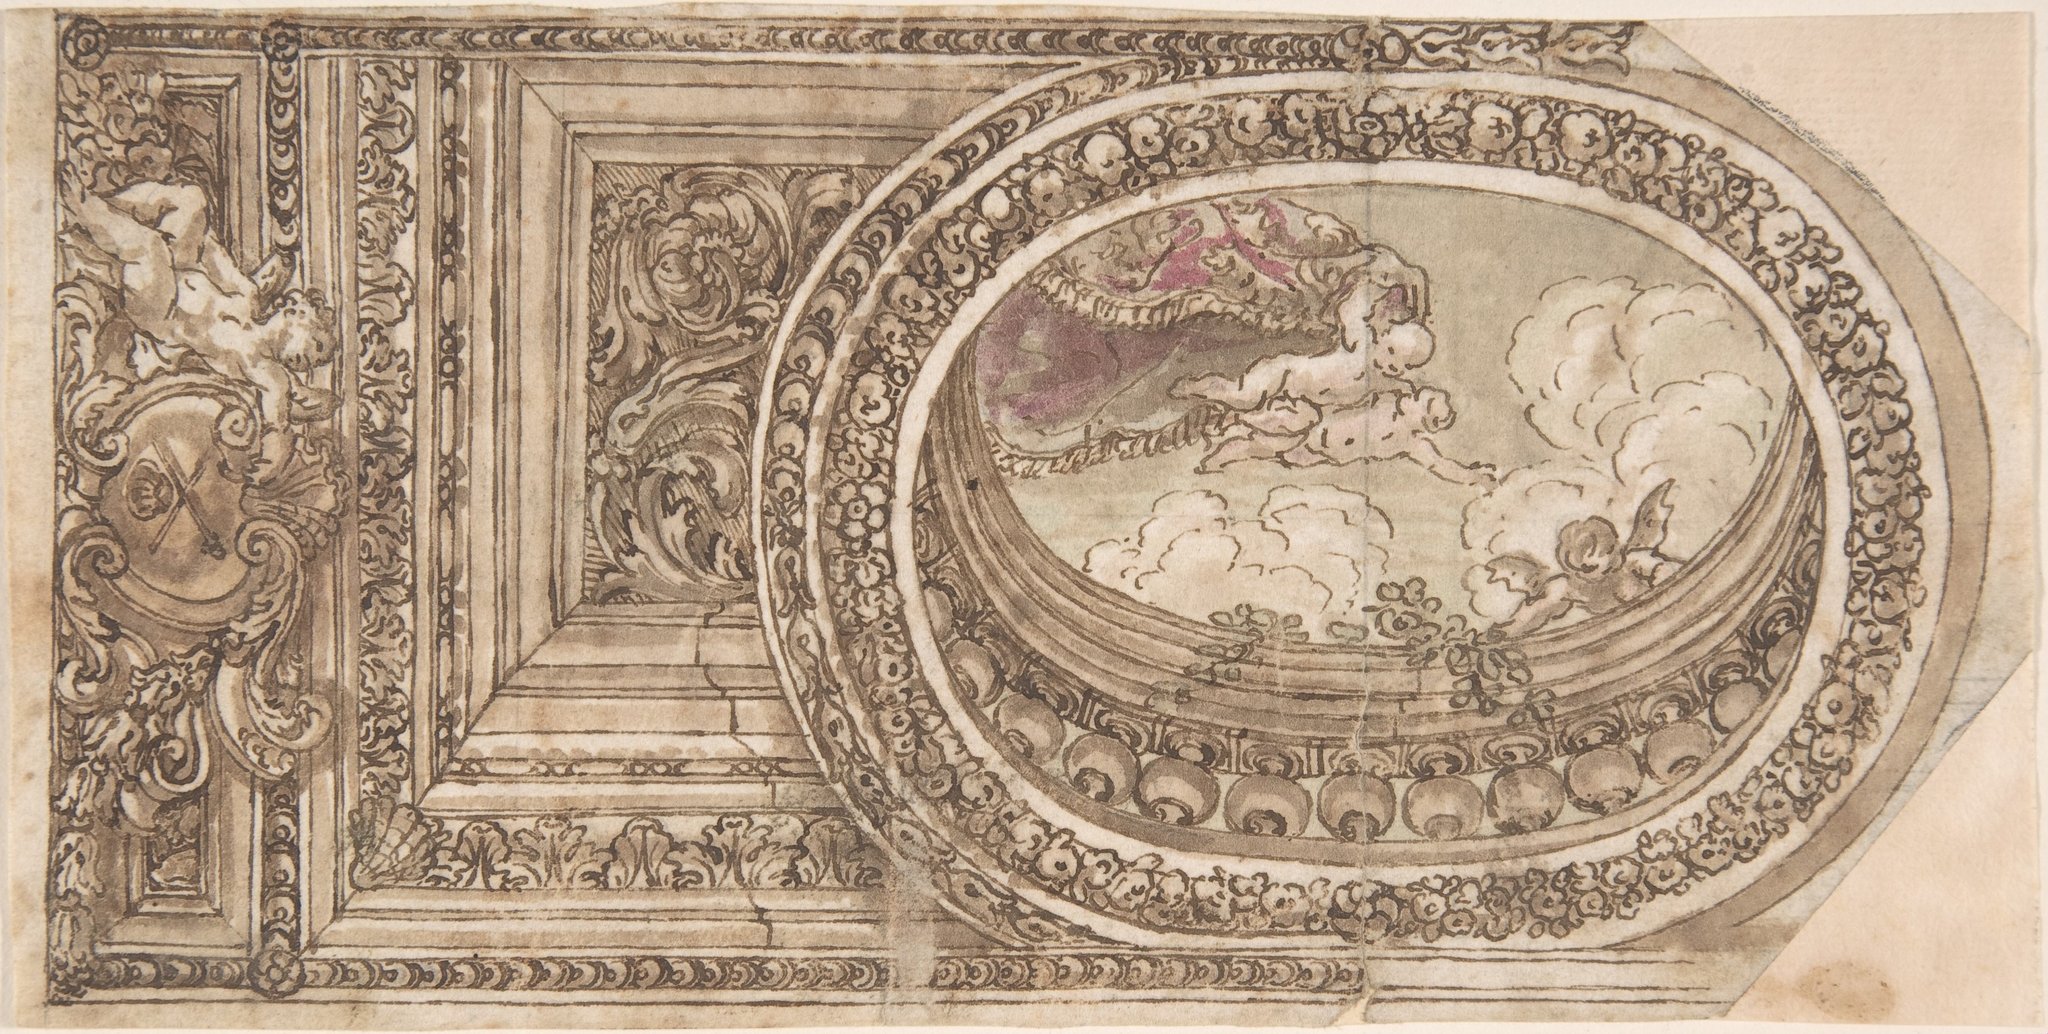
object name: drawing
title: Design for a Ceiling with an Oval Trompe L'Oeil Painting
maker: anonymous, italian, 17th century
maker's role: artist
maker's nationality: italian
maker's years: 1600-1700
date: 1601-1700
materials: graphite, ink, watercolor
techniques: brush, pen, wash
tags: ceilings